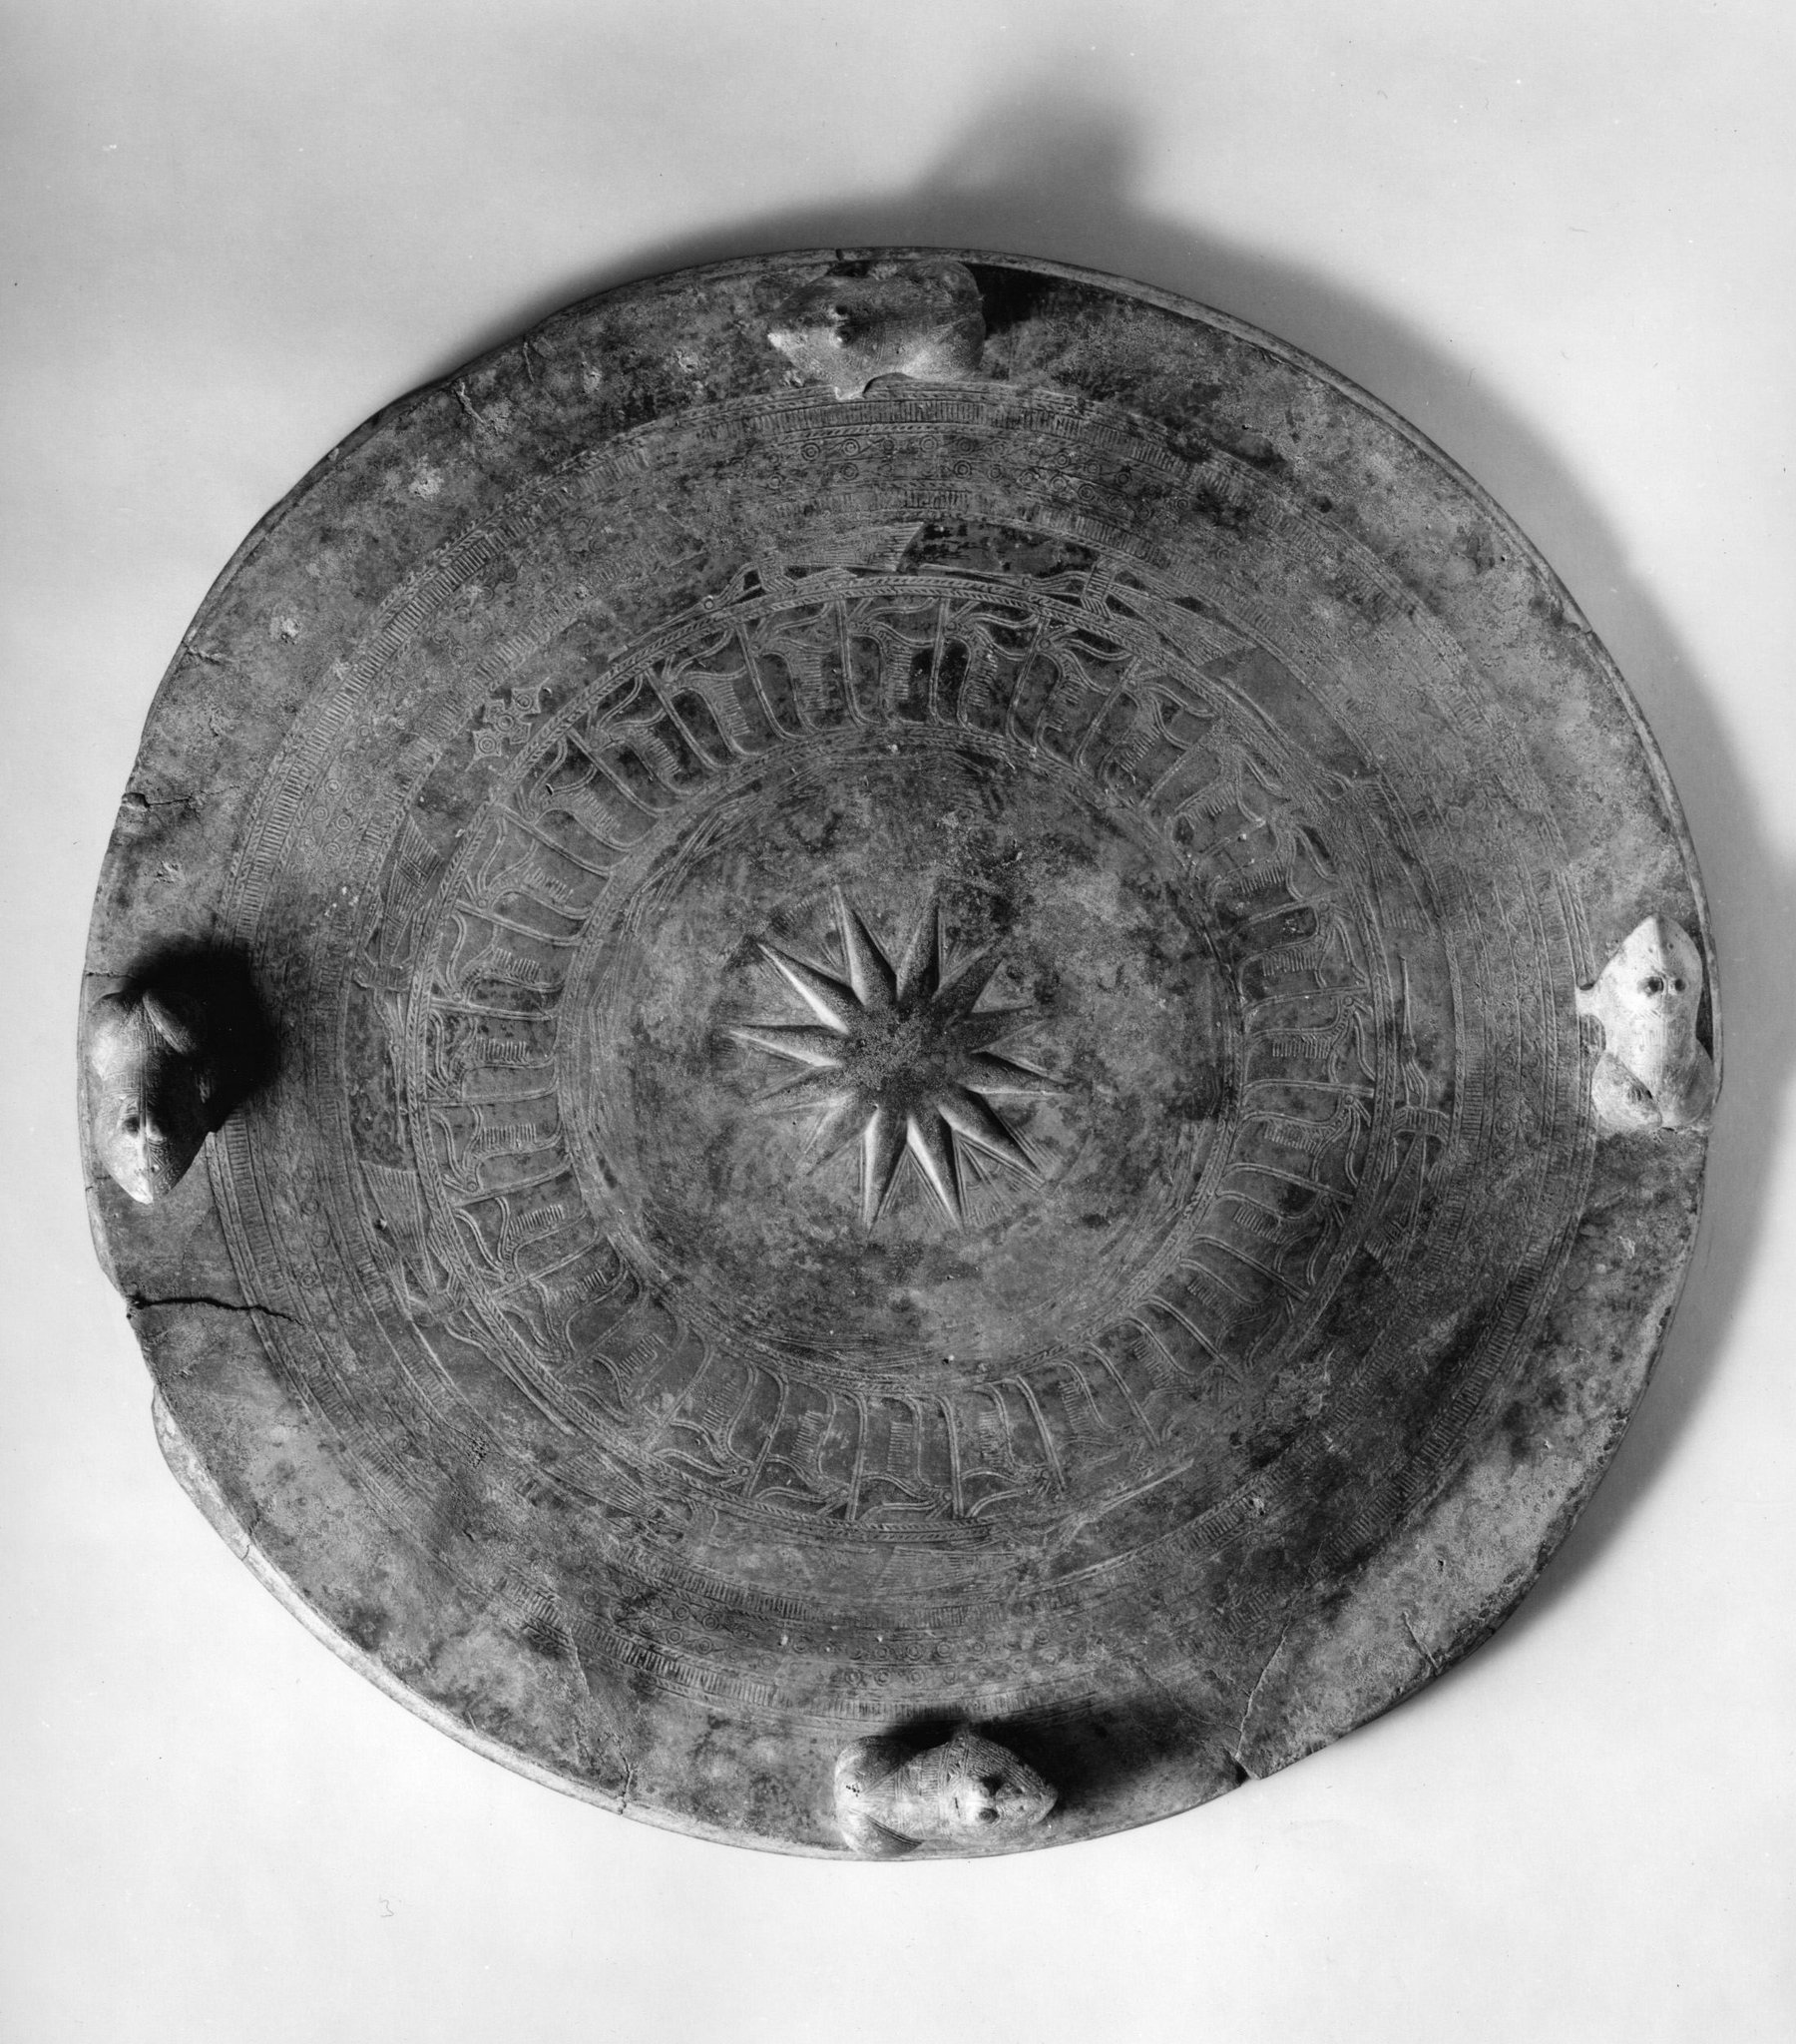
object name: tympanum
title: Tympanum of a Heger I Kettledrum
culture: vietnamese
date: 500 BCE-300 CE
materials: bronze